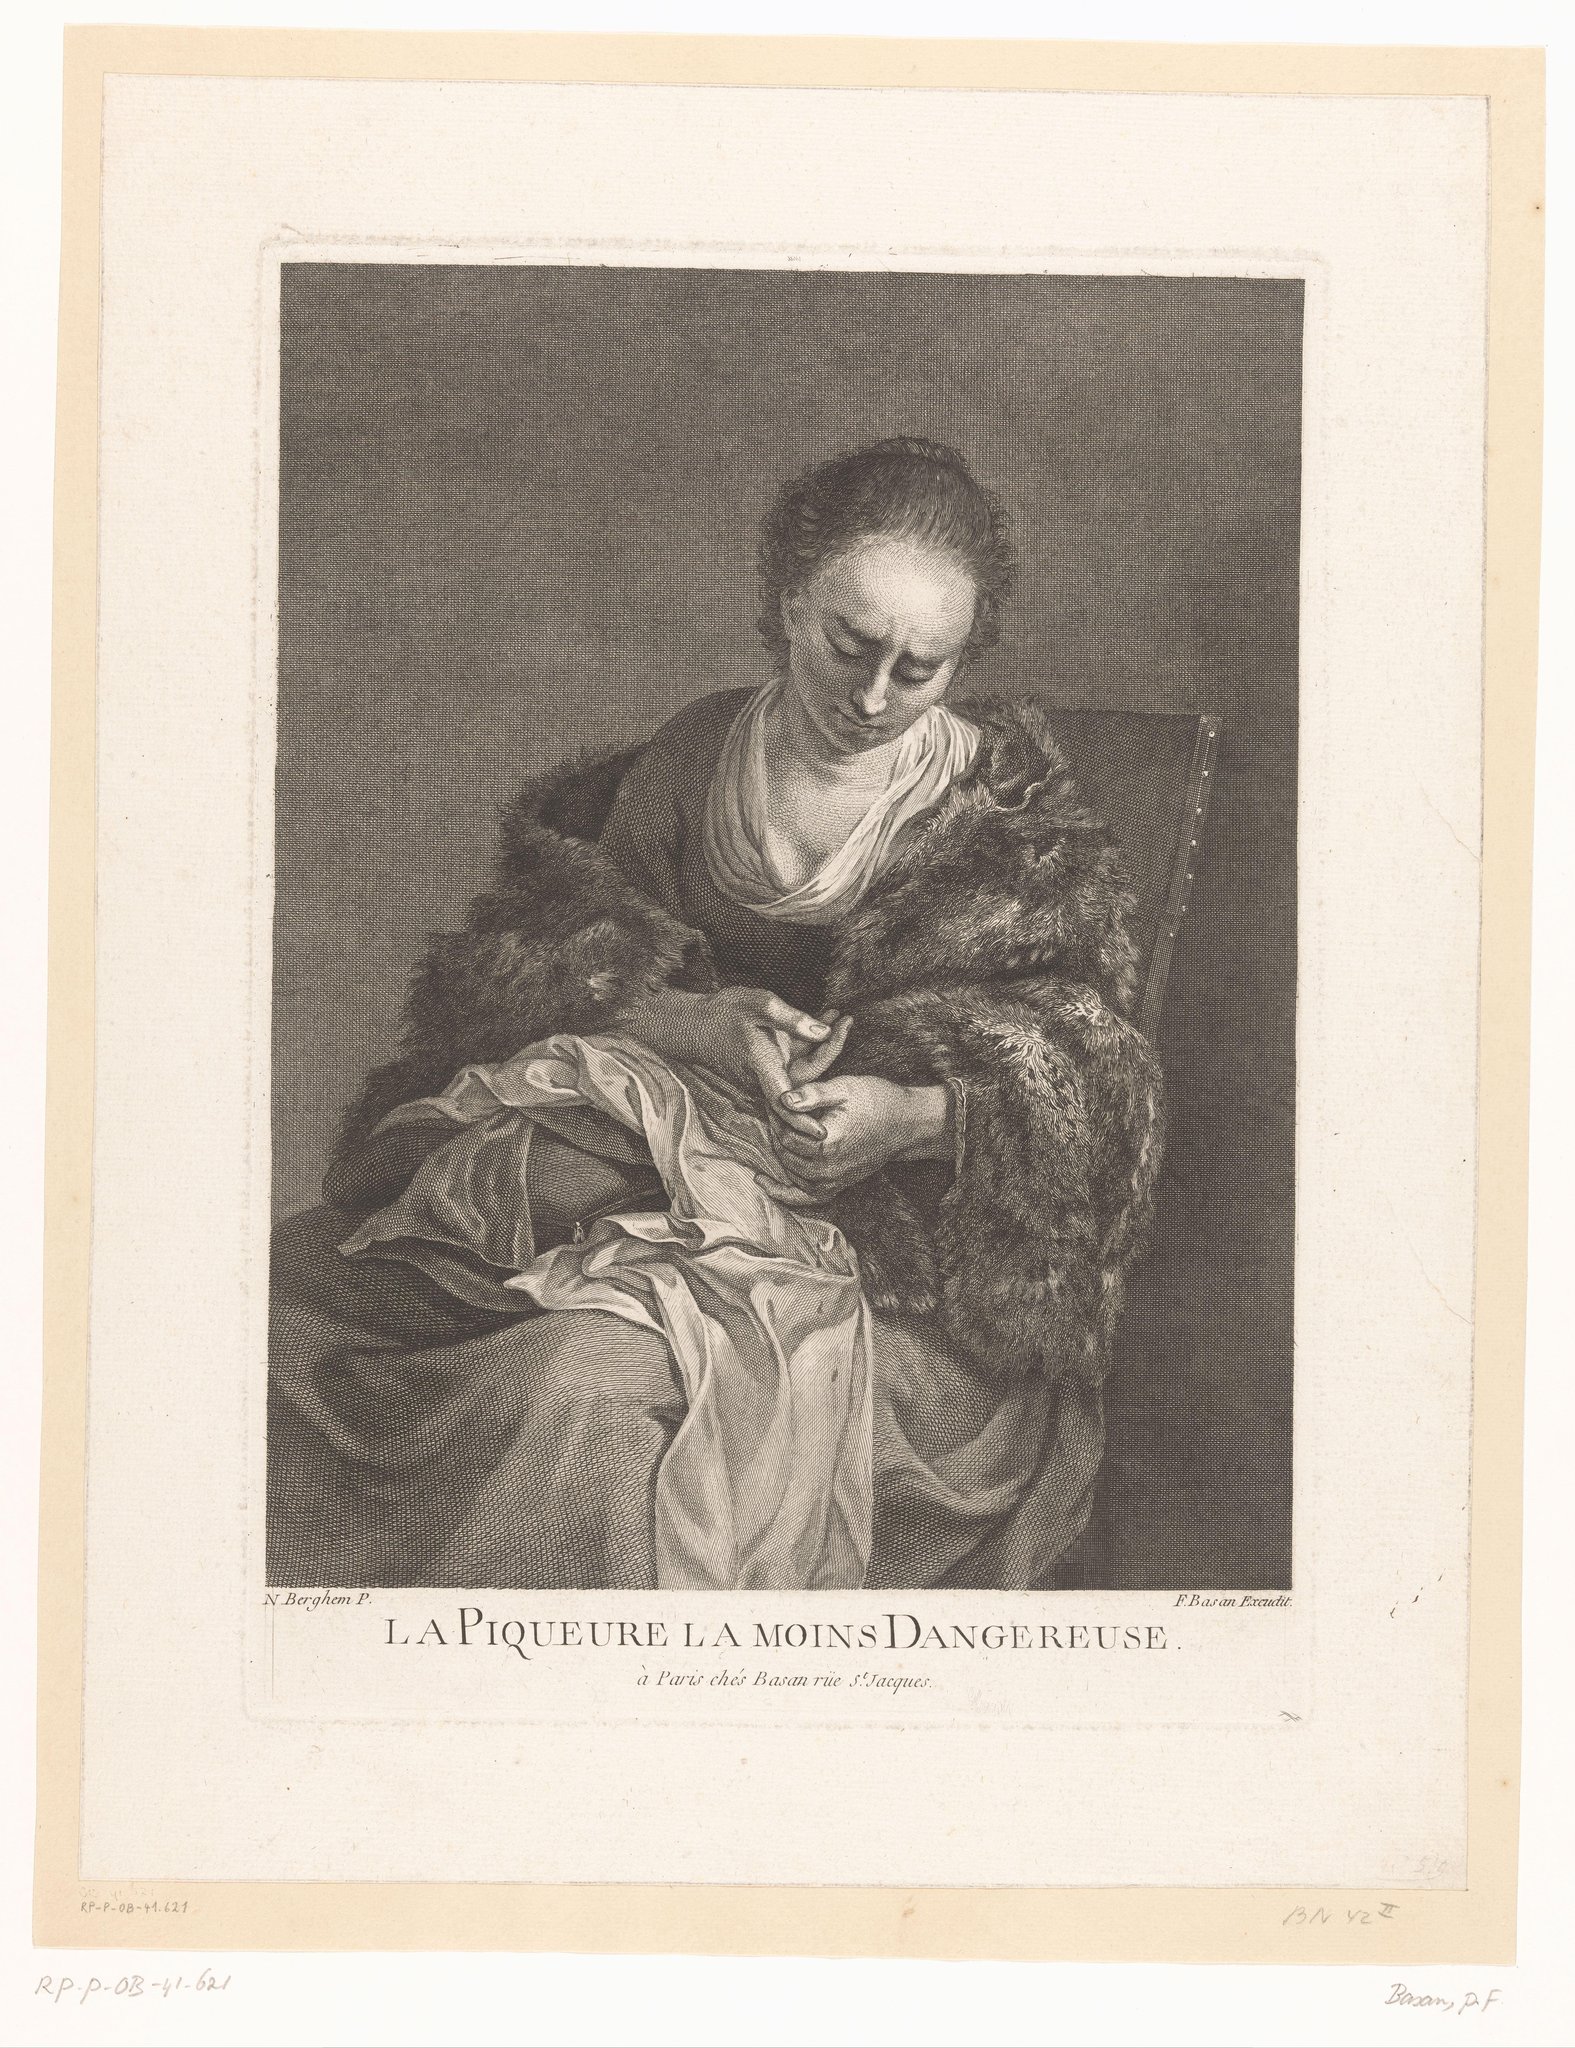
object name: print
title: Zittende vrouw met naaiwerk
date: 1733-1797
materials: paper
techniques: engraving, etching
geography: paris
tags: pain, sitting on an elevation - aa - female human figure, sewing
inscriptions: collector's mark: Lugt 240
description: Met pijn vertrokken ogen wendt een zittende vrouw haar bloedende vinger af van haar naaiwerk.